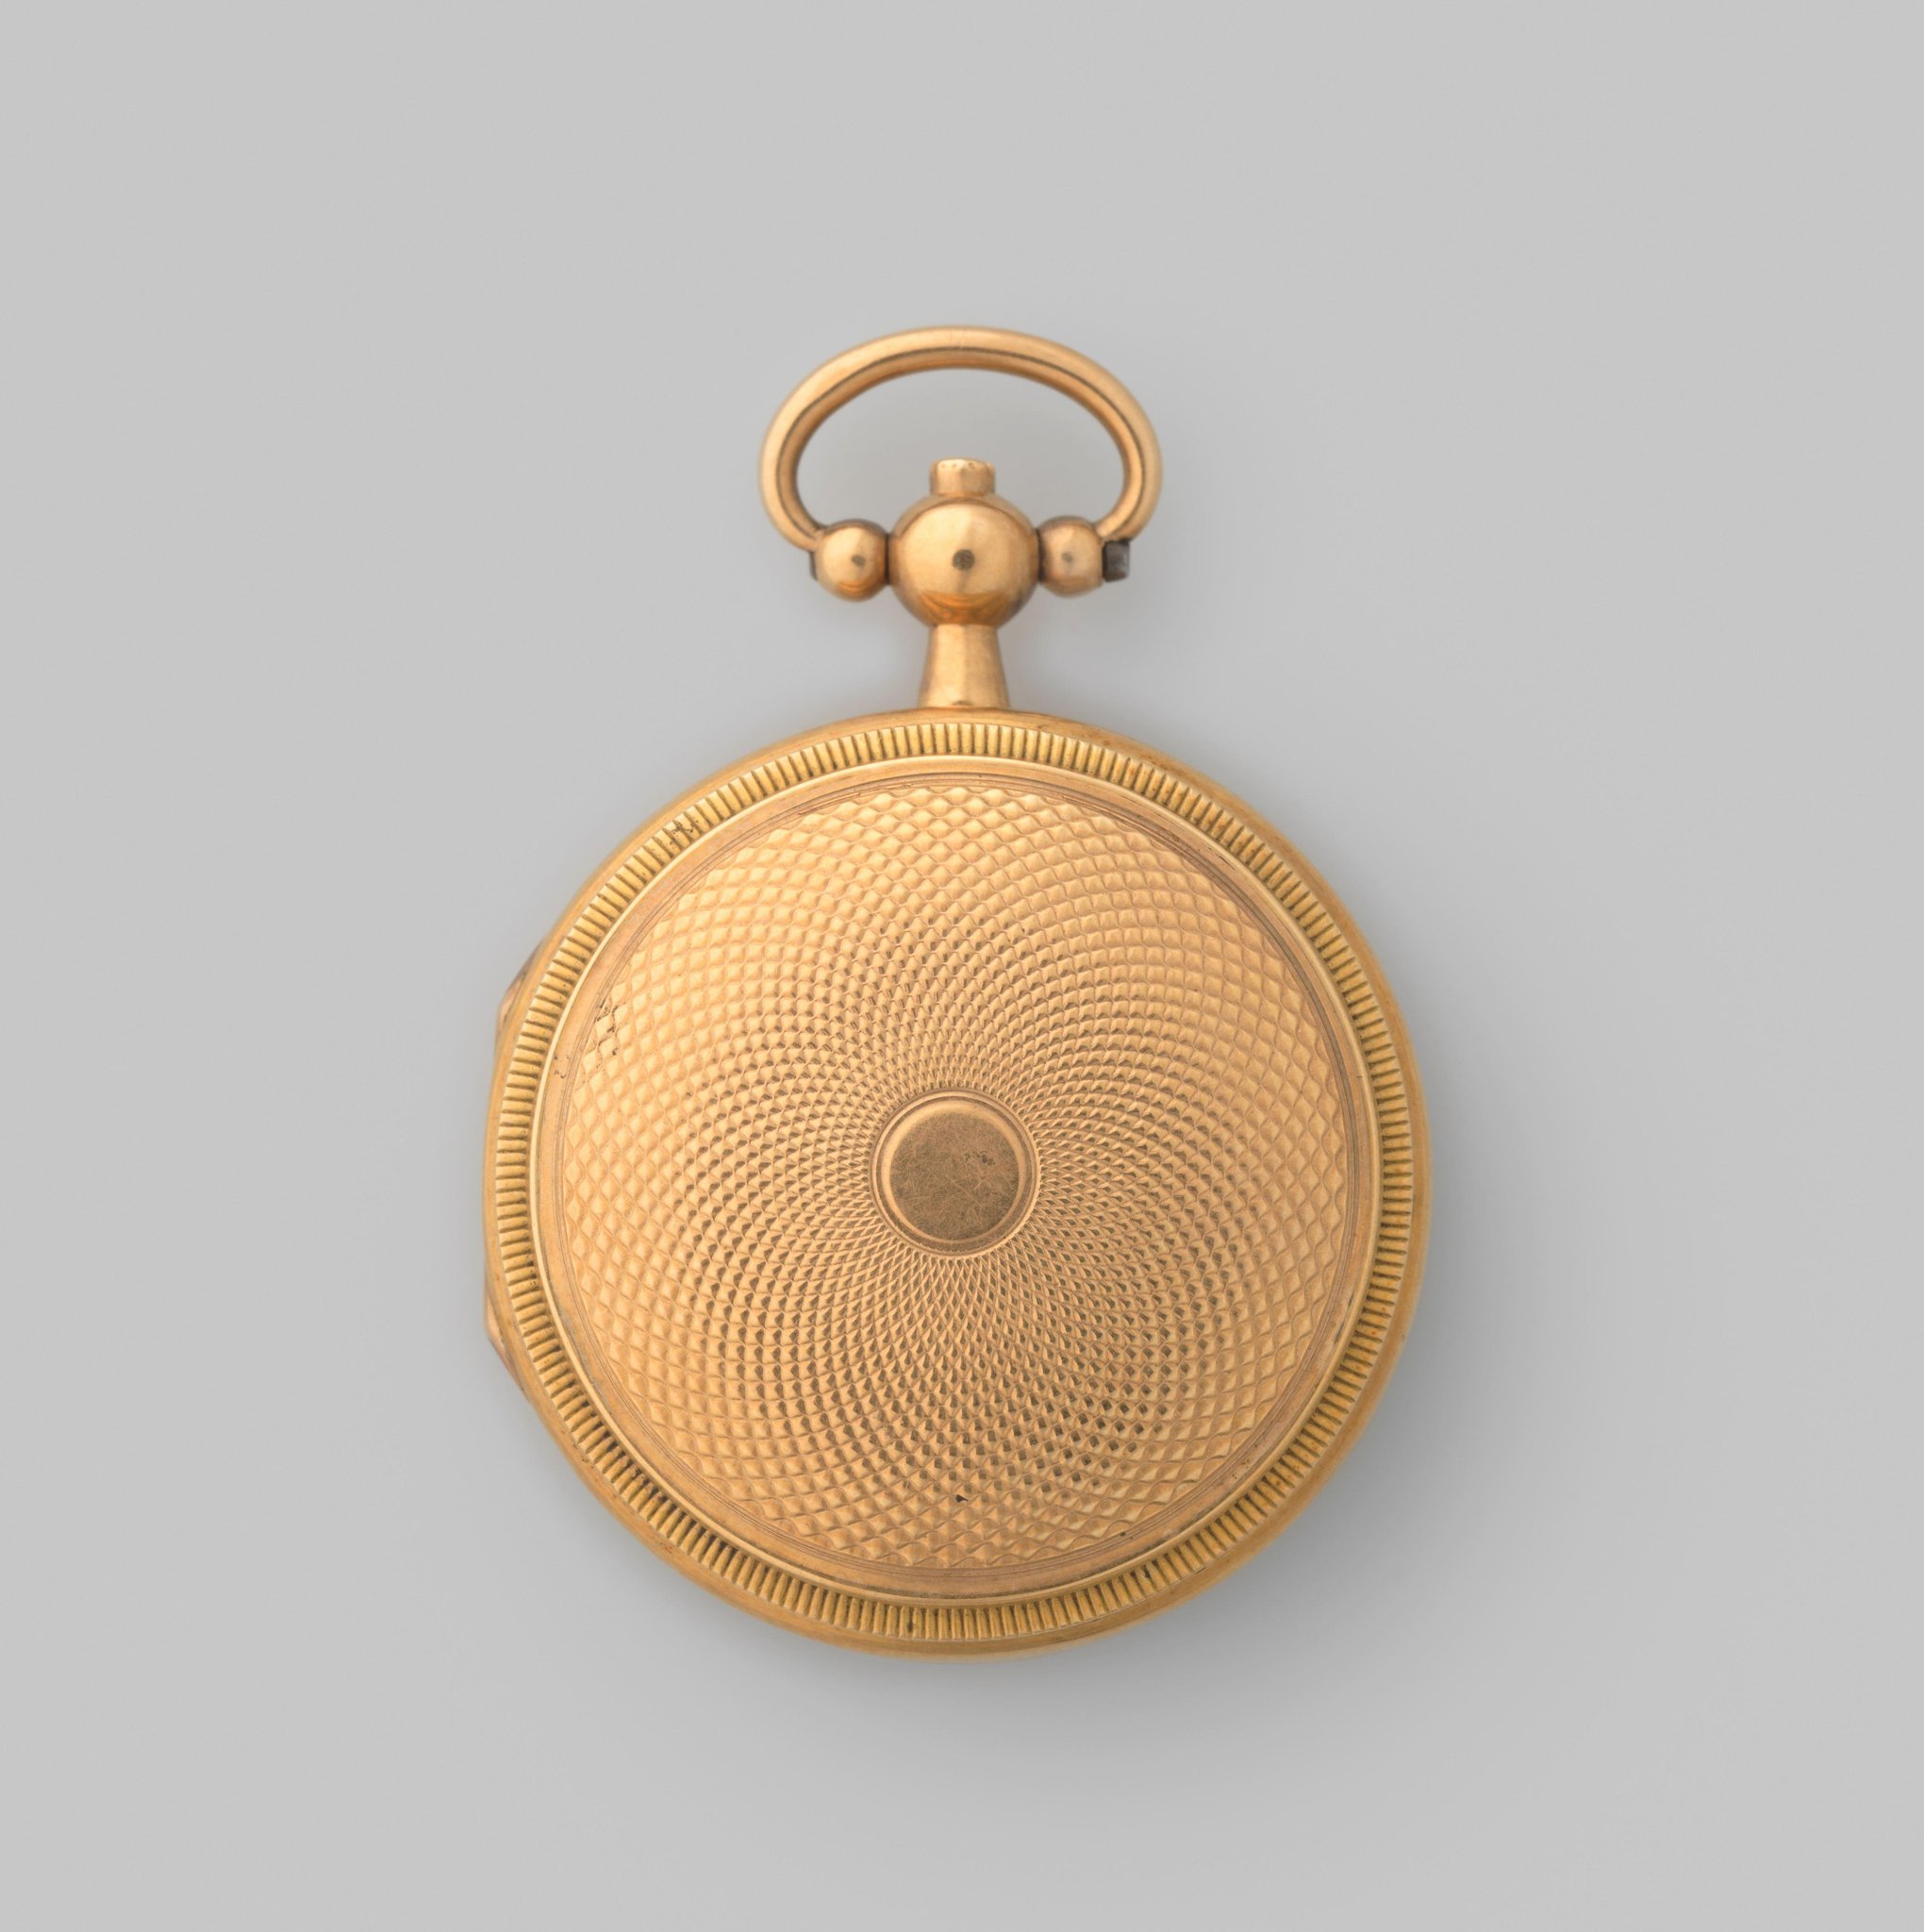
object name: dameshorloge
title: Dameshorloge van goud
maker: Anonymous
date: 1840-1860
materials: gold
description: Dameshorloge van goud. De voor- en achterbodems zijn geheel geguillocheerd. De wit geëmailleerde wijzerplaat heeft Arabische cijfers.